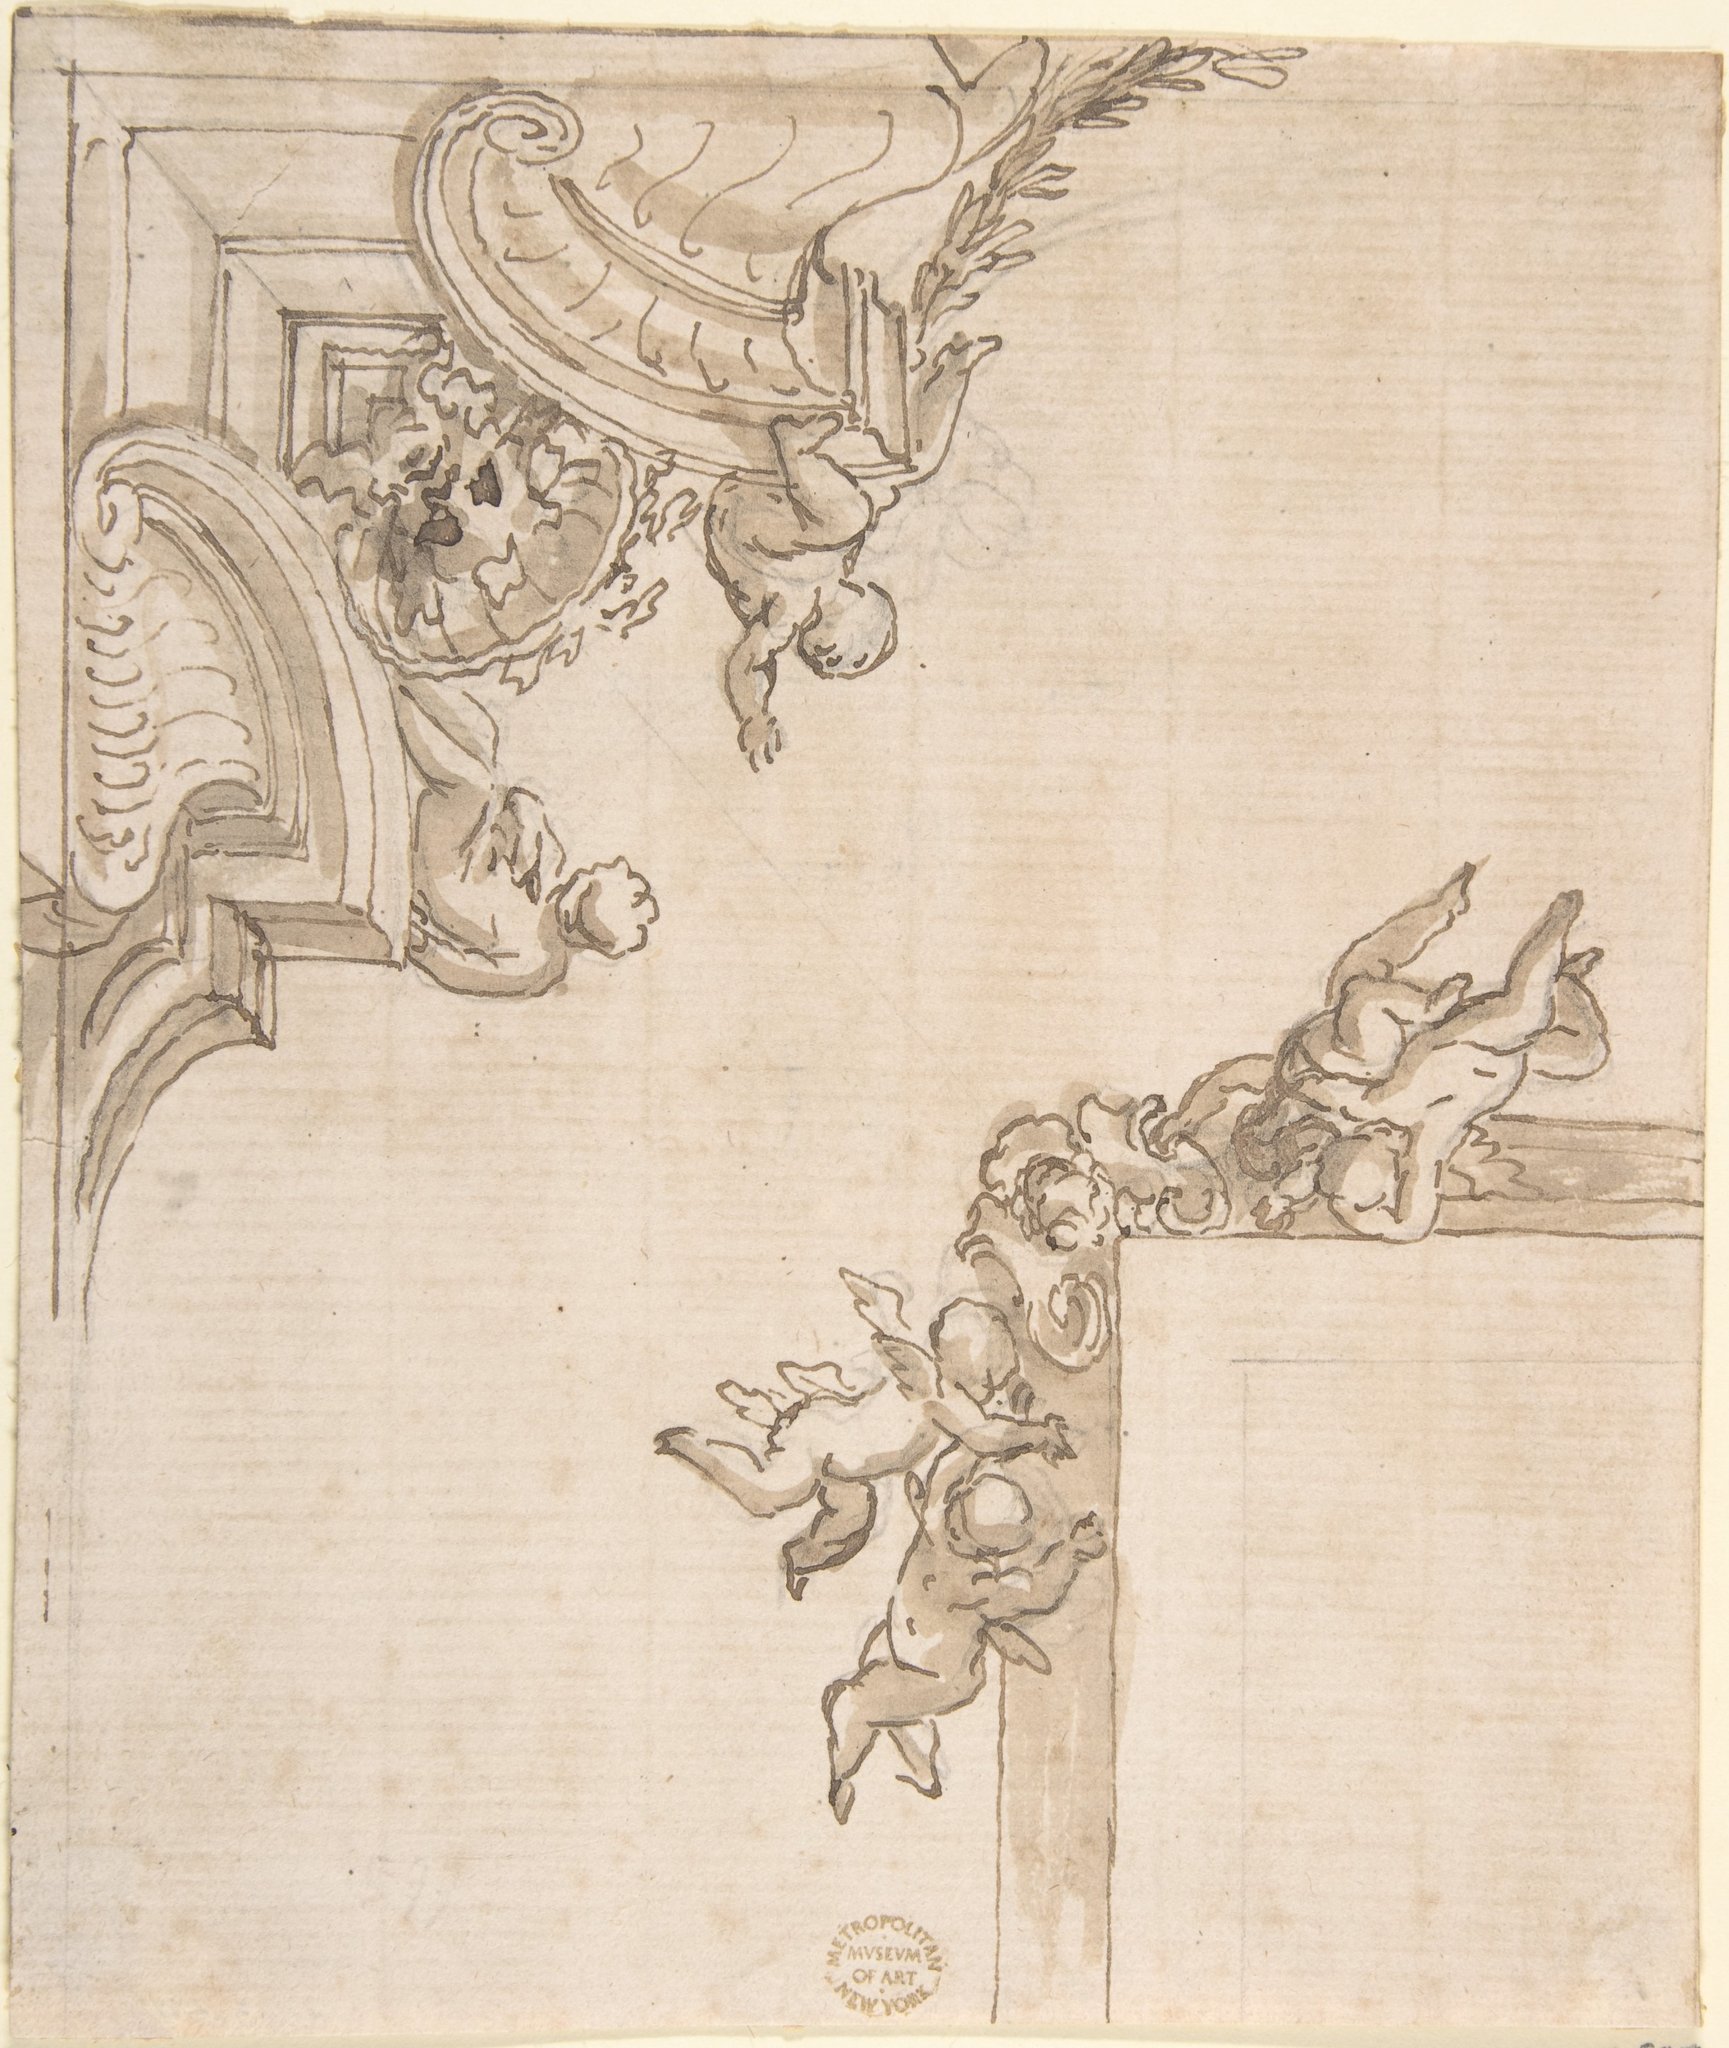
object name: drawing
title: Ceiling Decoration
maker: anonymous, italian, 17th century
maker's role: artist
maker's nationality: italian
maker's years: 1600-1700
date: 1601-1700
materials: ink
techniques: pen, wash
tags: ornament